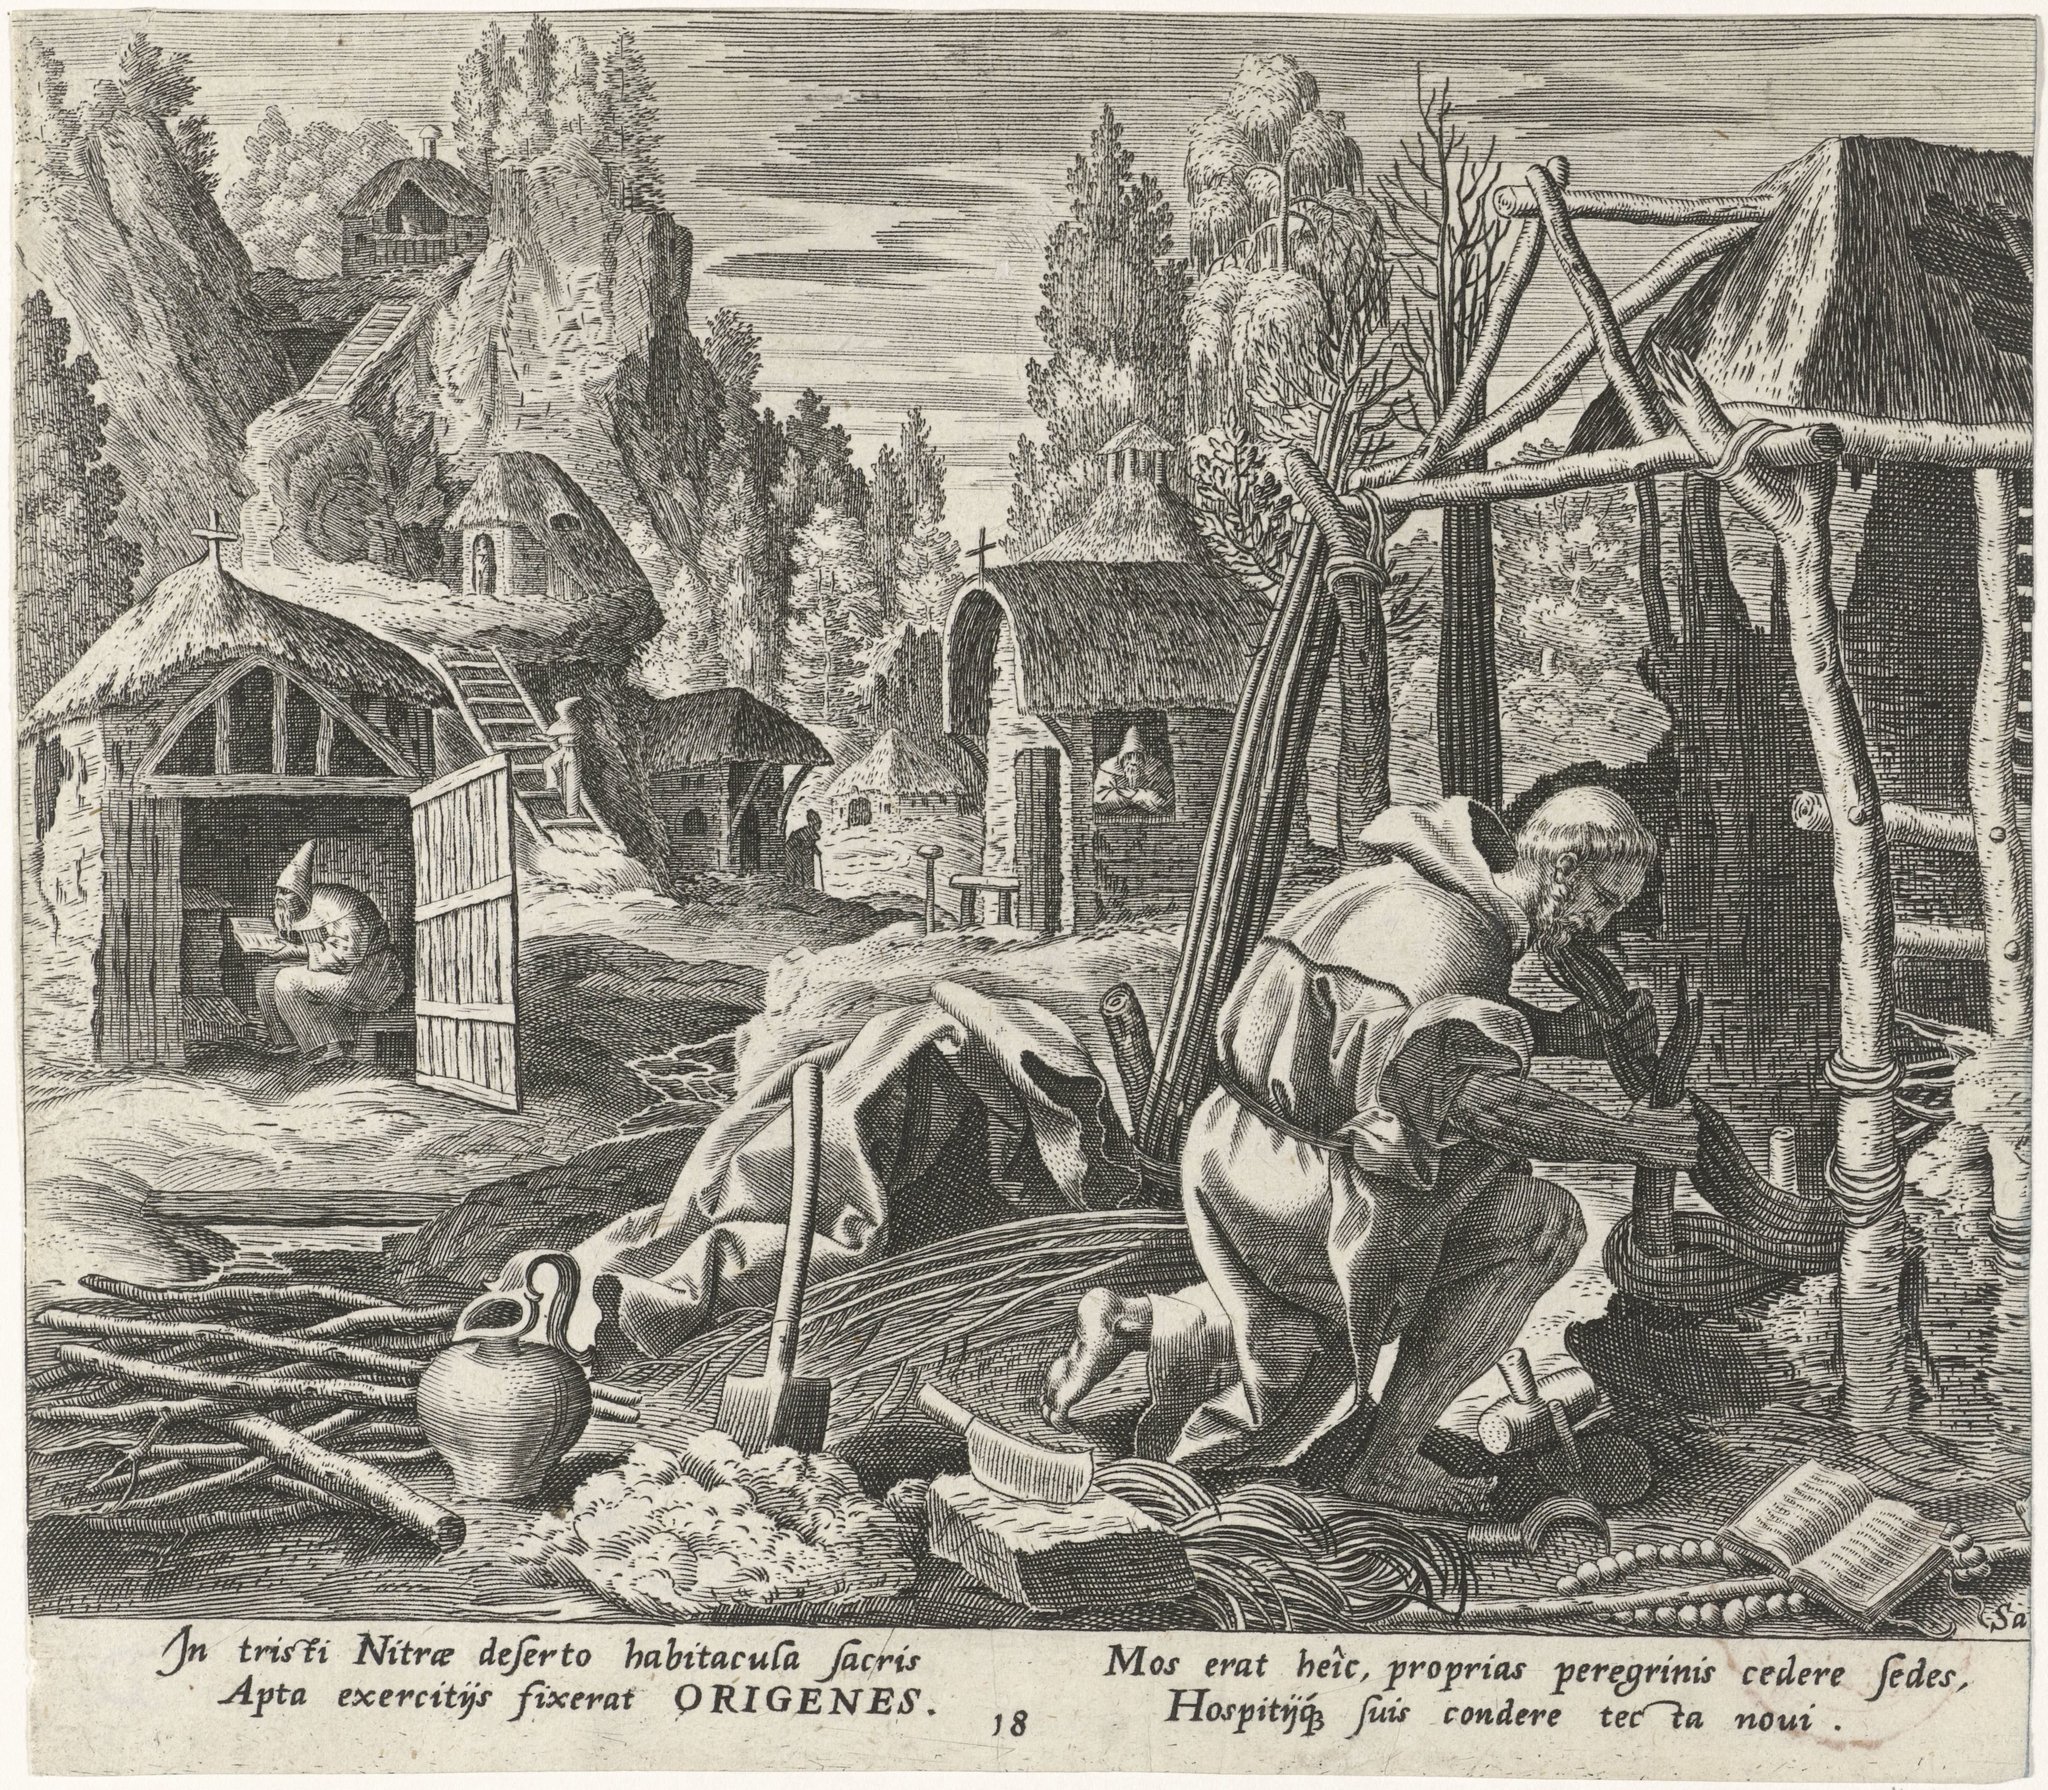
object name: print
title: Origen de kluizenaar in de Nitrische woestijn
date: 1583-1588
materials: paper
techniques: engraving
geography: antwerp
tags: withdrawal into the wilderness or desert ~ ascetic life, anchorite, hermit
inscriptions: collector's mark: Lugt 240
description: Op de voorgrond Origen de kluizenaar. Hij maakt een hut in de woestijn van Nitra. Andere hutjes met kluizenaars op de achtergrond.